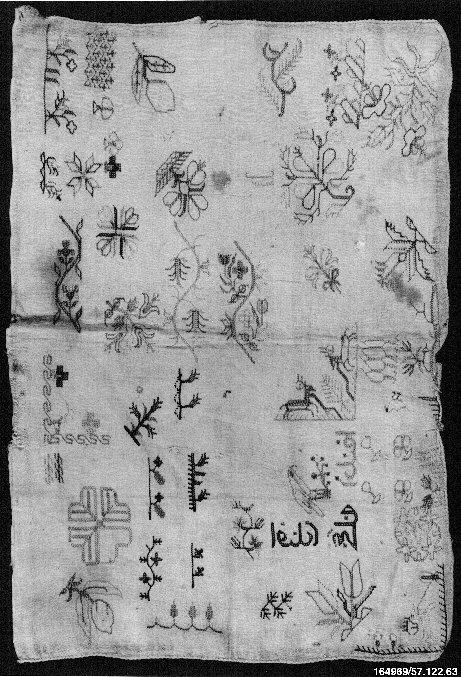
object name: sampler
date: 1801-1900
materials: cotton, silk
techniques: embroidery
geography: turkey